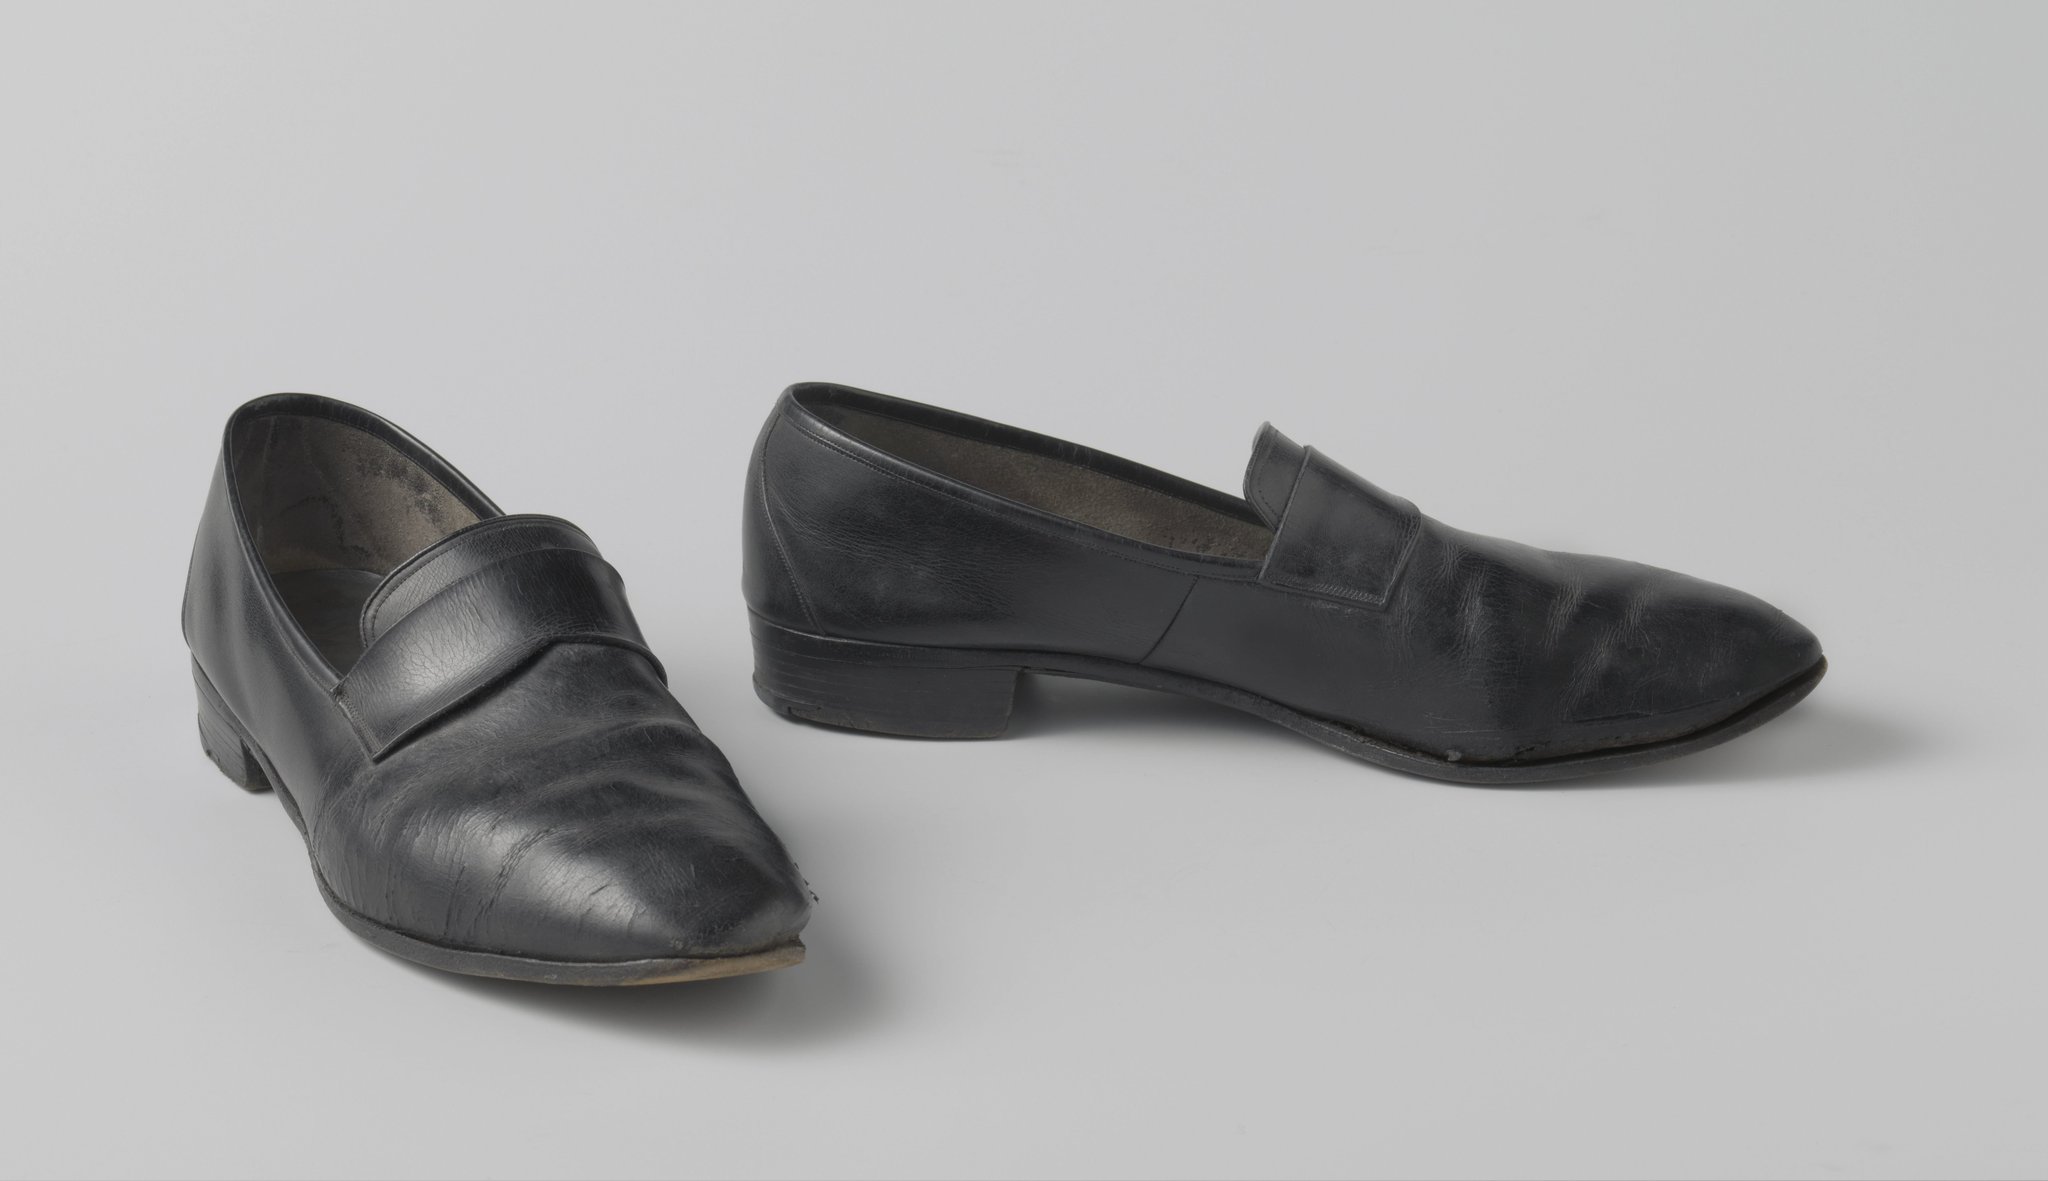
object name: shoe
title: Schoen van zwart leer, laag model, hoog voorblad met vaste wreefbanden en met afgeronde puntneus en lage hak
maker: Anonymous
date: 1915-1925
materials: leather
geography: netherlands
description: Linkerschoen van zwart leer. Laag model, hoog voorblad, als tong iets uitkomend onder vaste wreefbanden. Puntneus, maar afgerond. Lage hak.